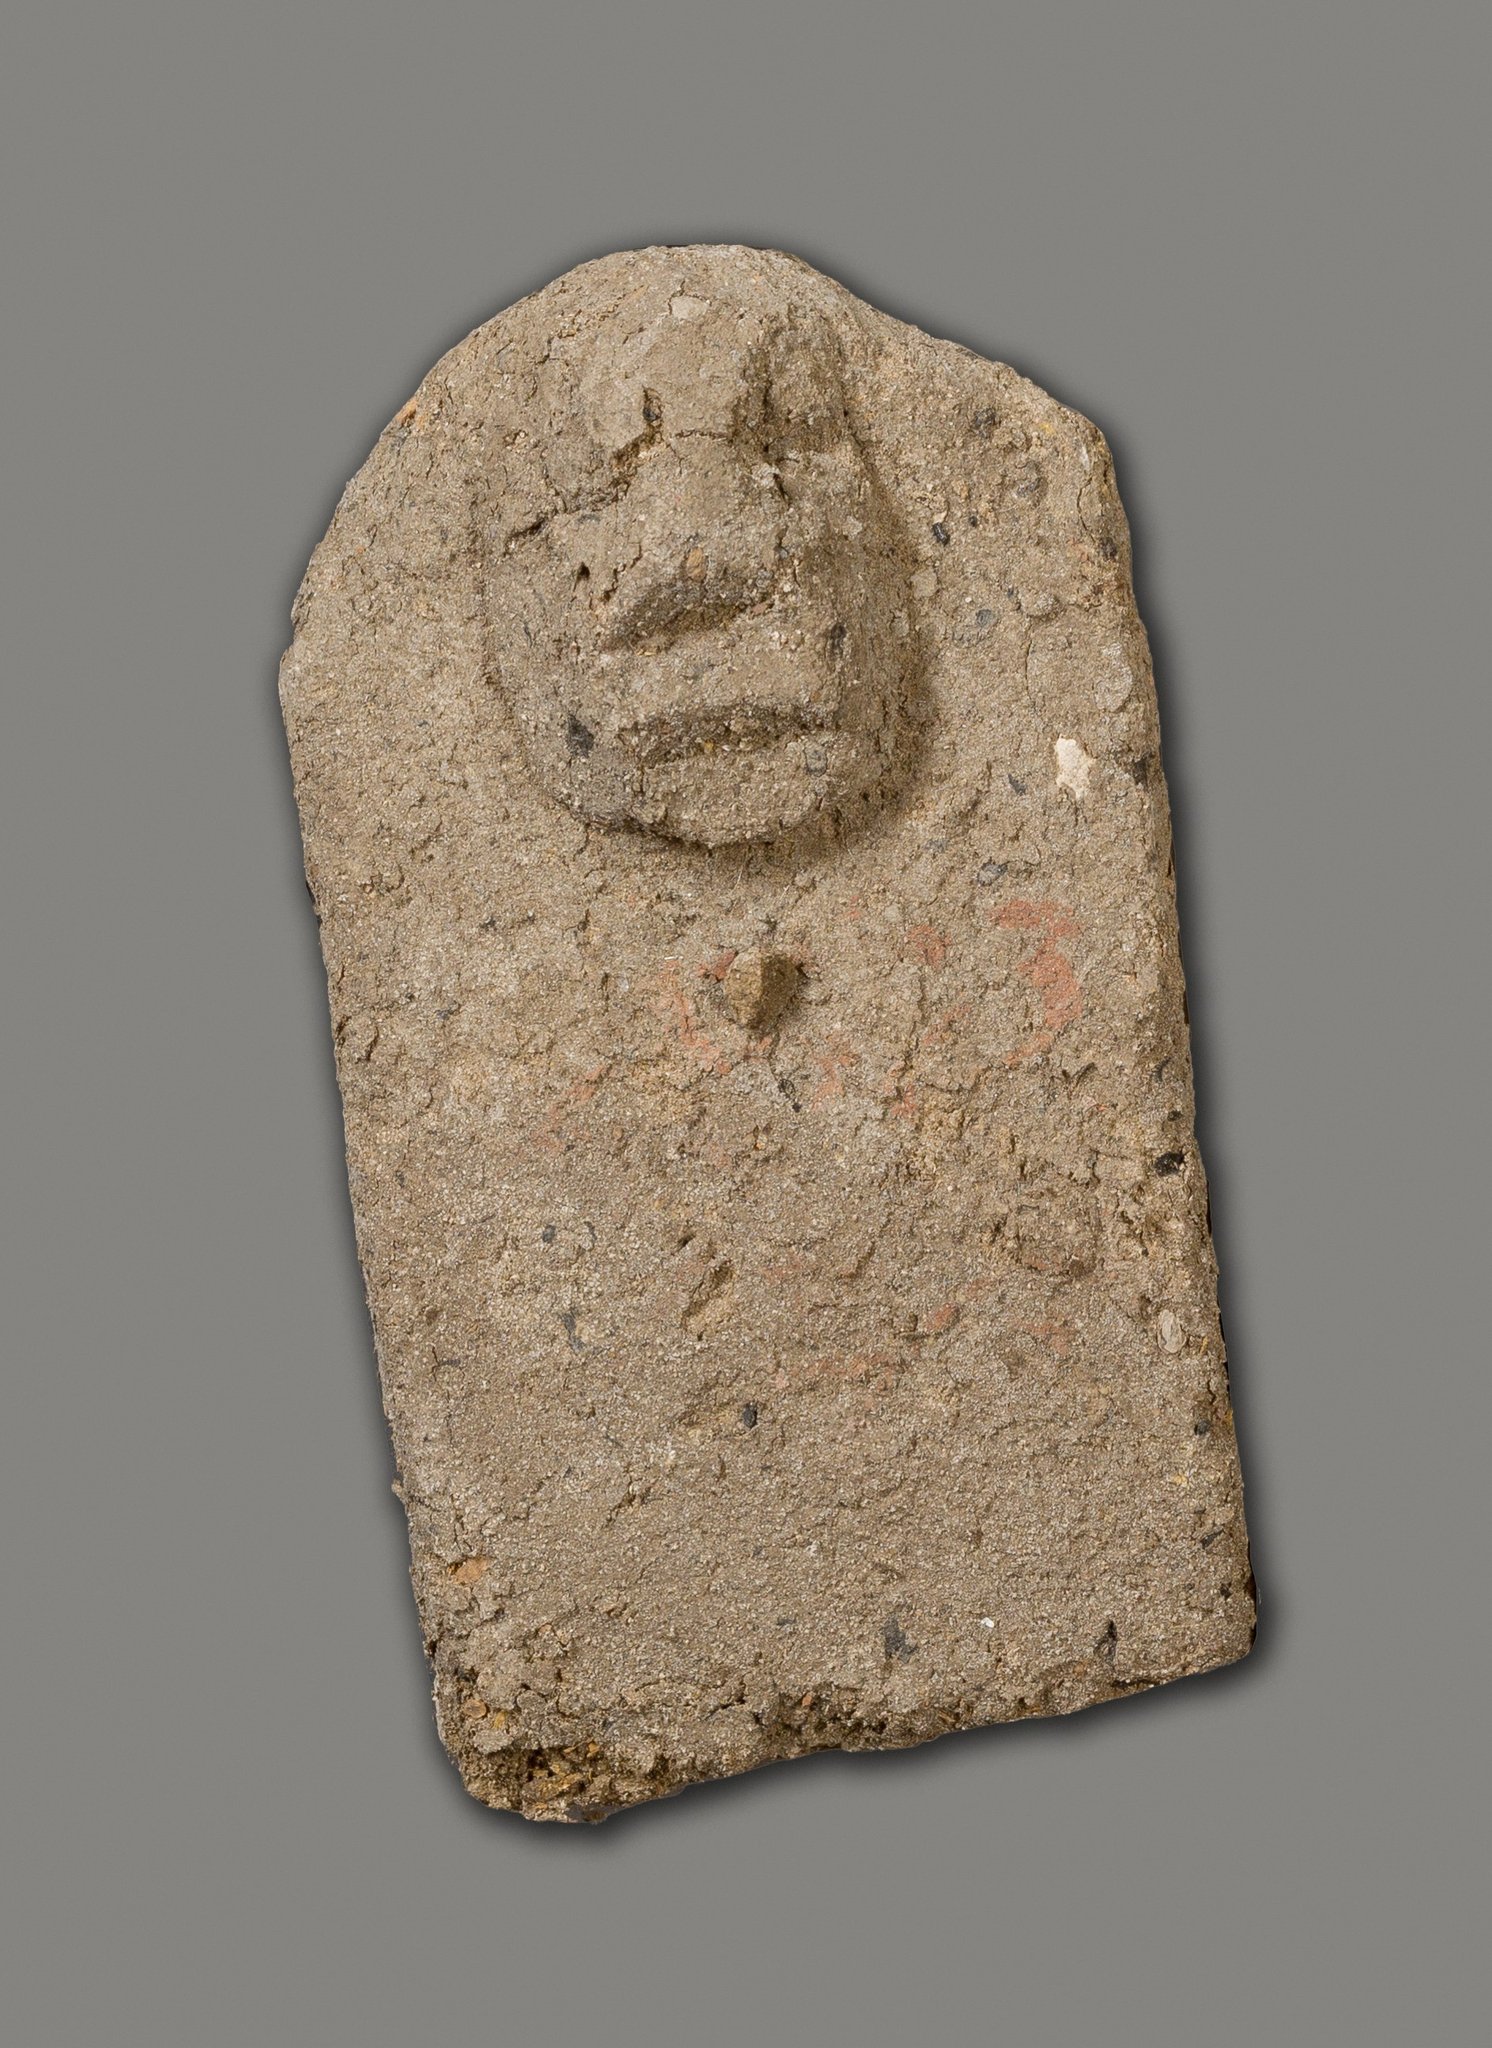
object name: figure, magical, execration, tablet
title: Magical Figure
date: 1802-1550 BCE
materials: clay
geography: egypt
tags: faces